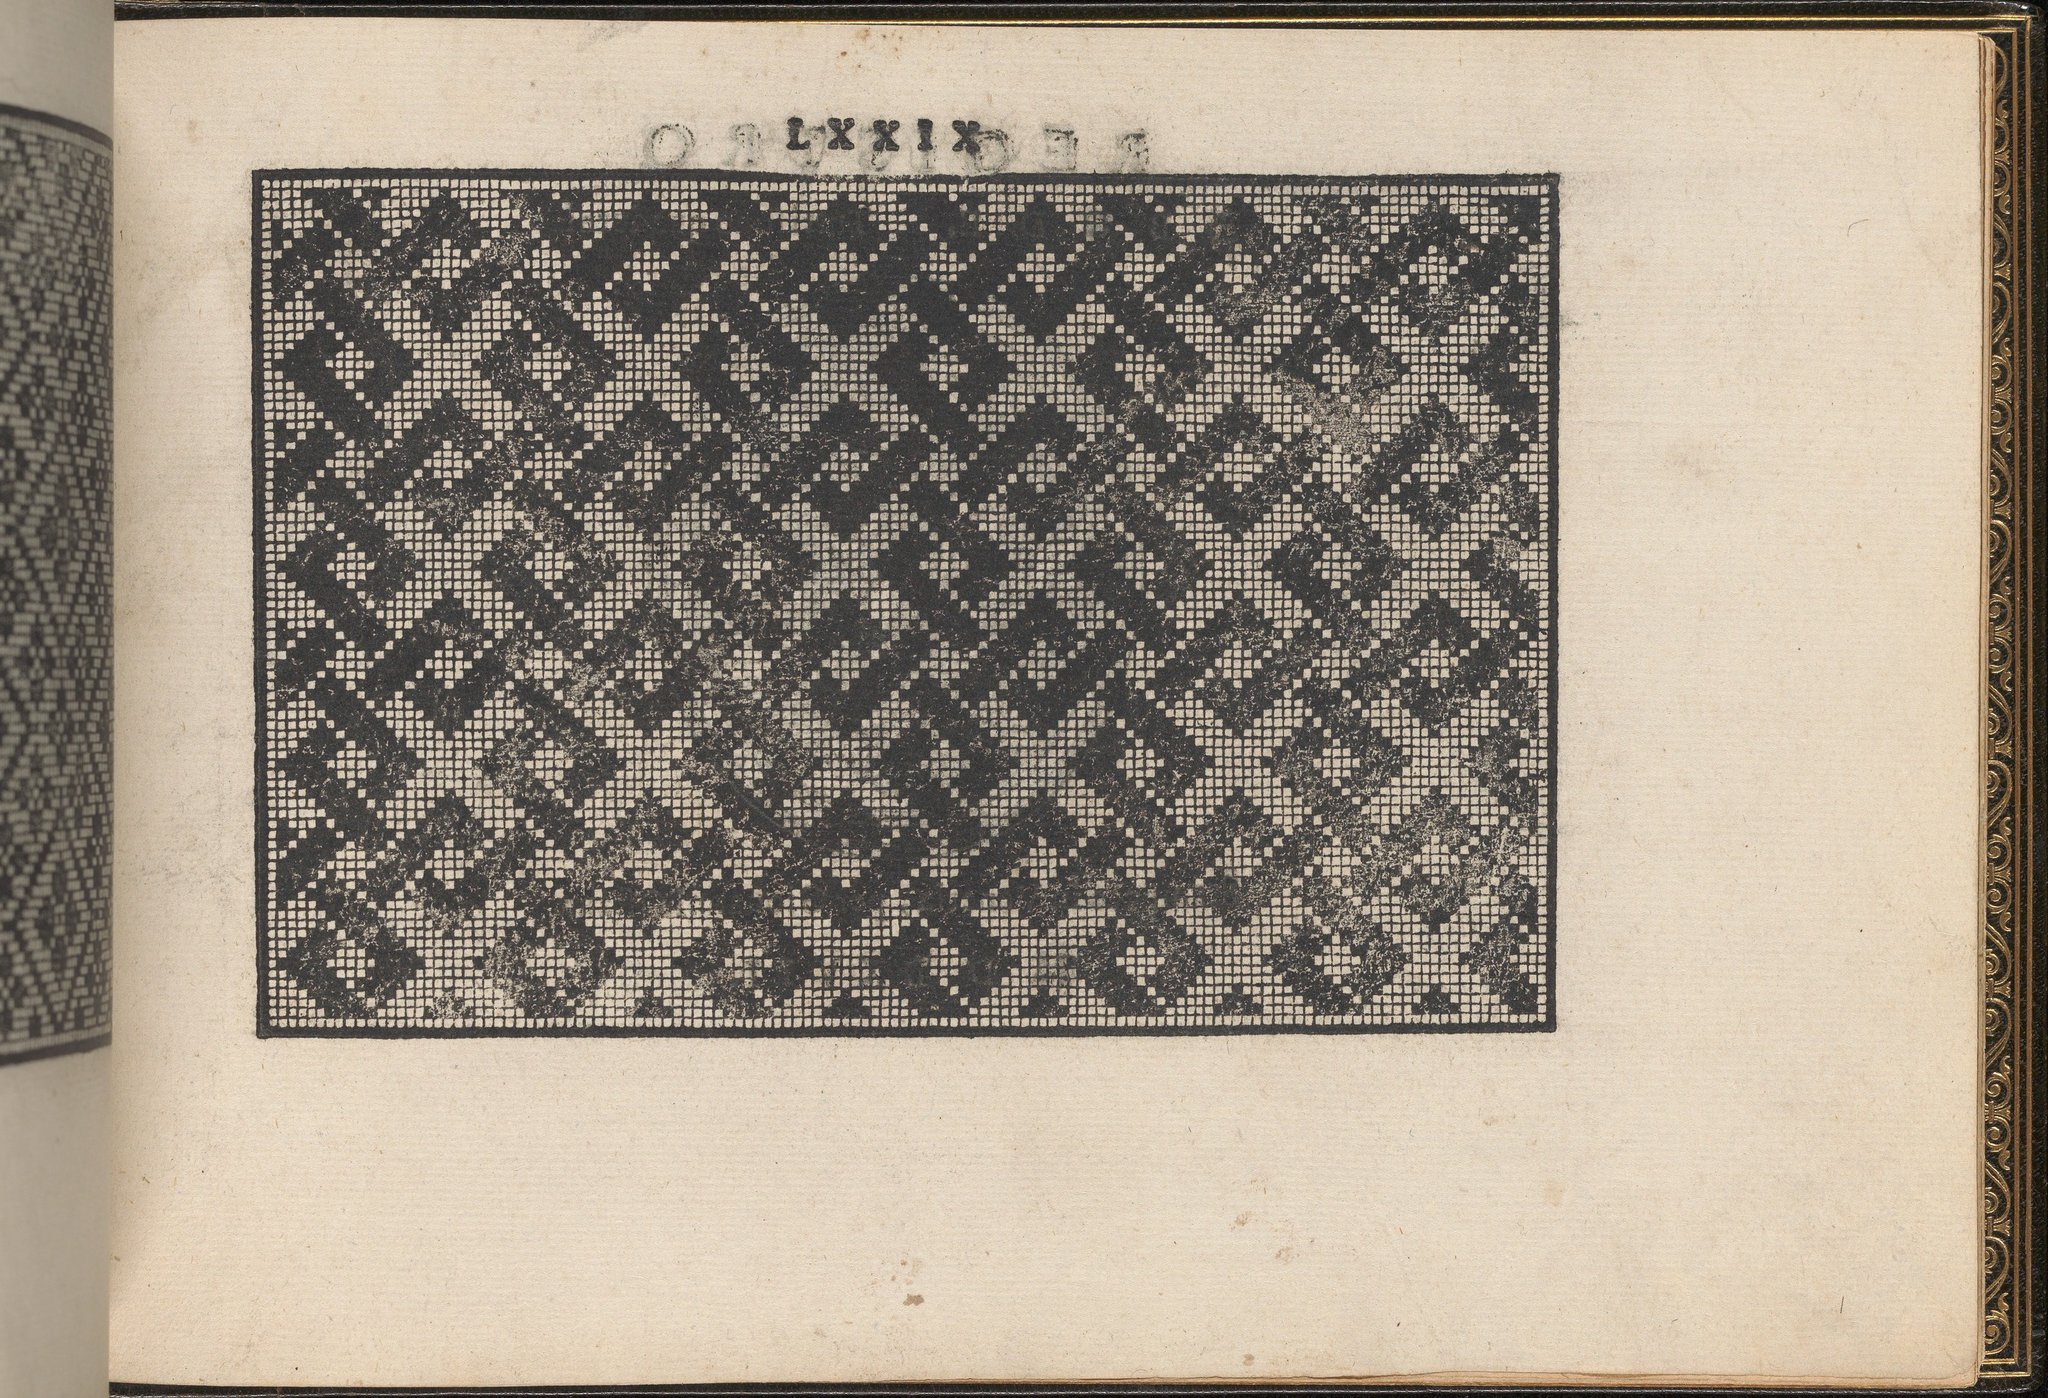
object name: book print ornament architecture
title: La Vera Perfettione del Disegno di varie sorti di recami, page 40 (recto)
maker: giovanni ostaus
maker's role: publisher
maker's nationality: italian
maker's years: 1507-1607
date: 1567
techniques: woodcut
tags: ornament